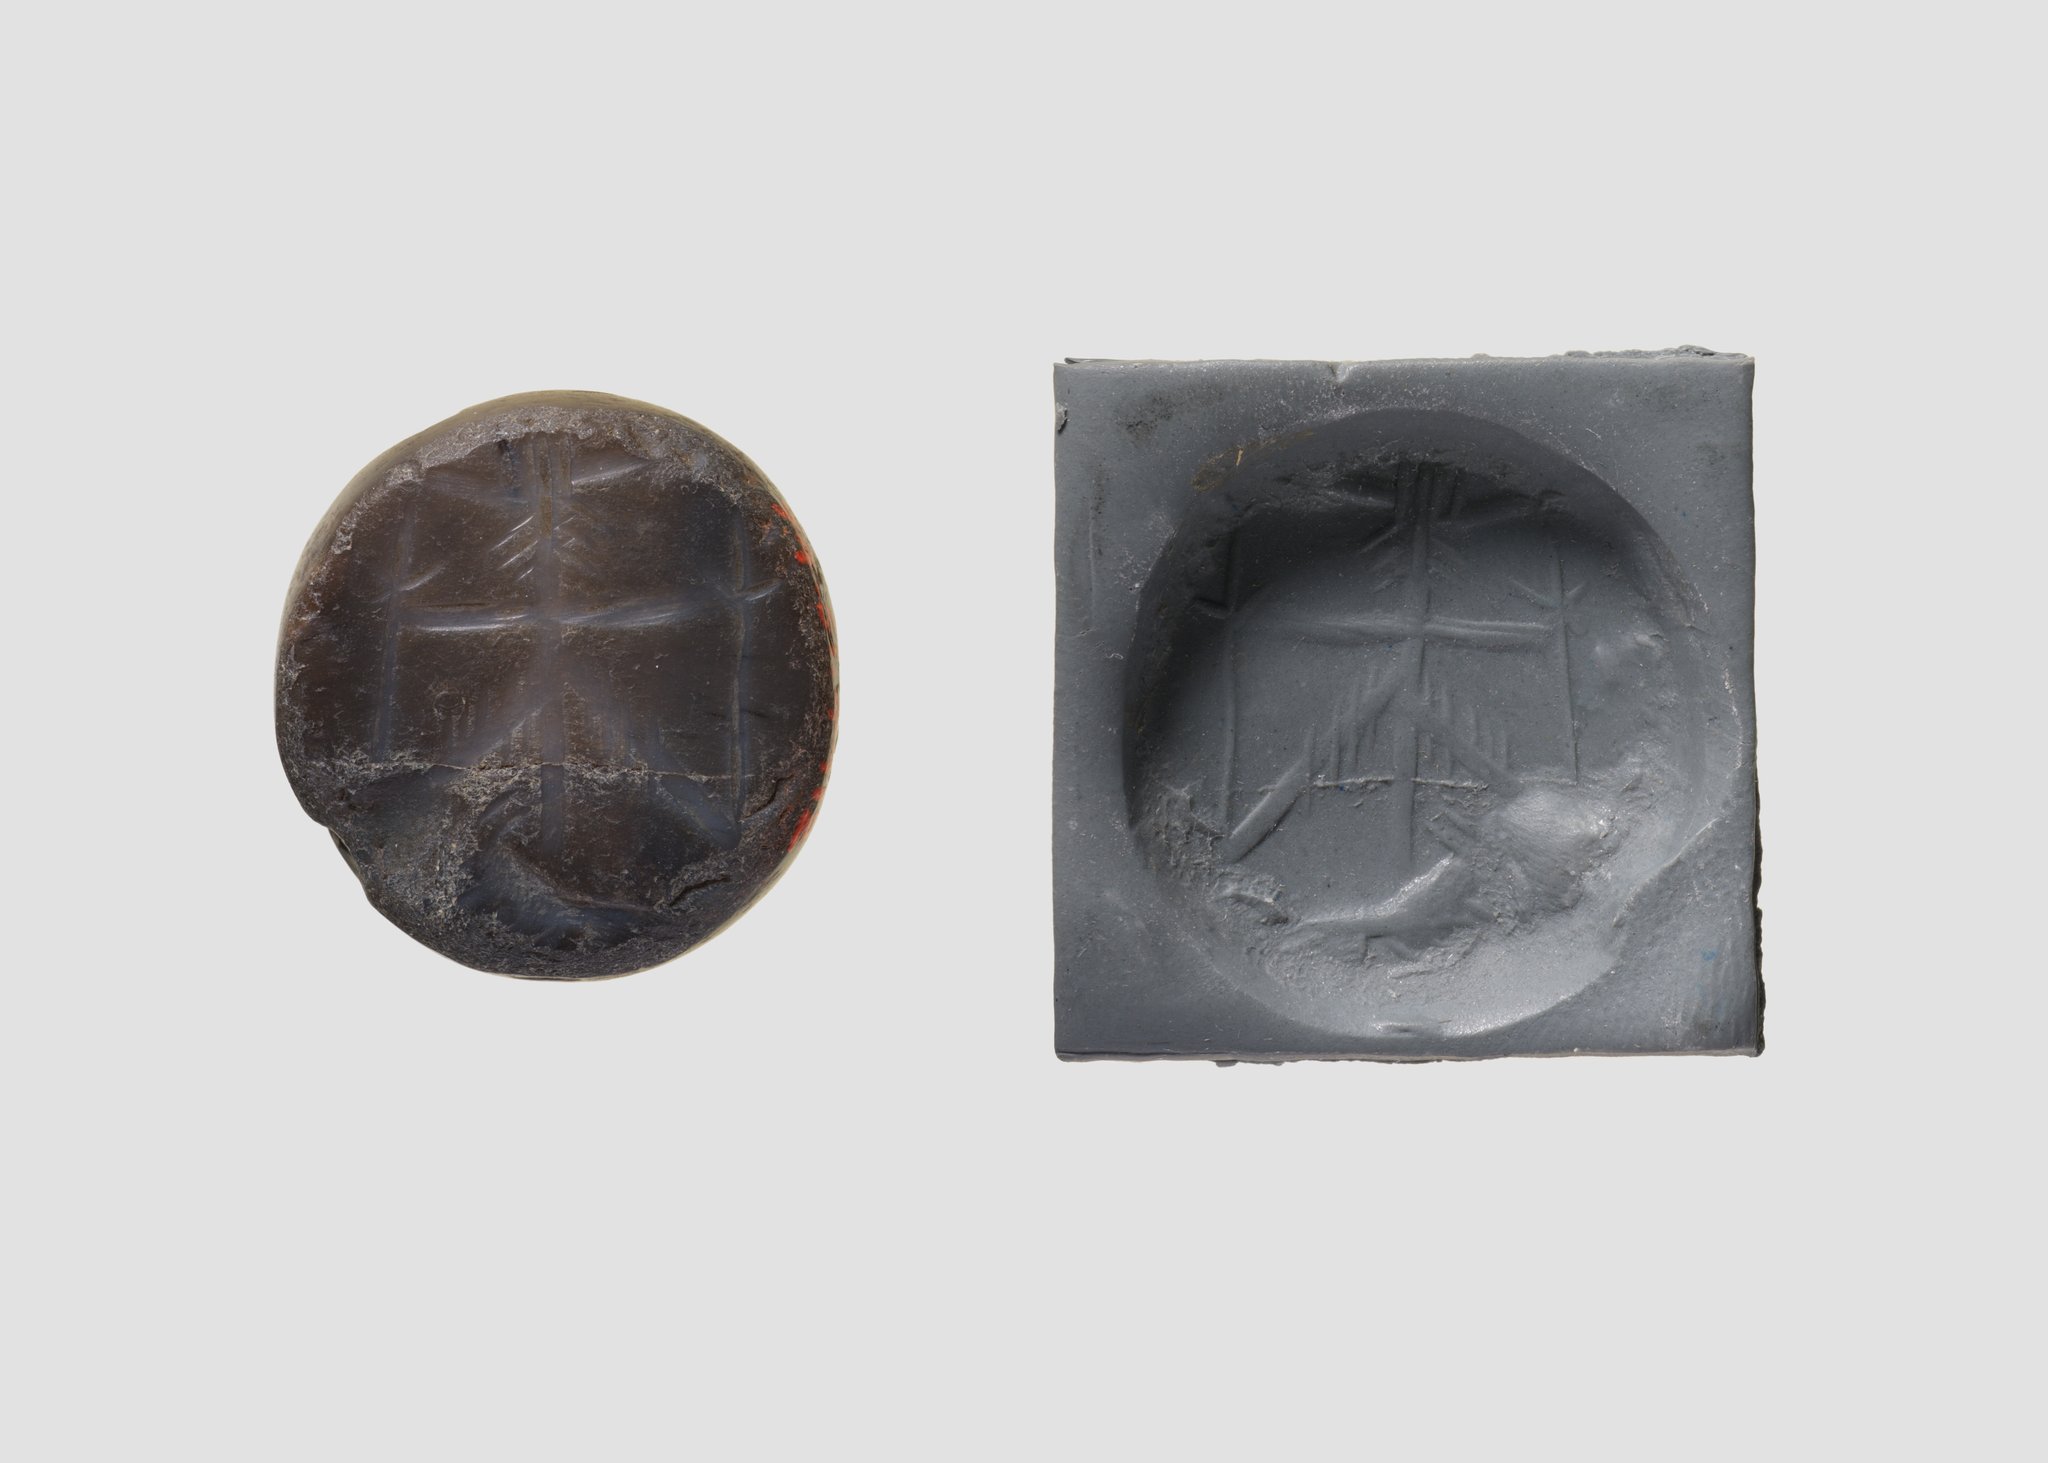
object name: stamp seal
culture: sasanian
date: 201-300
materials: stone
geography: iran or mesopotamia